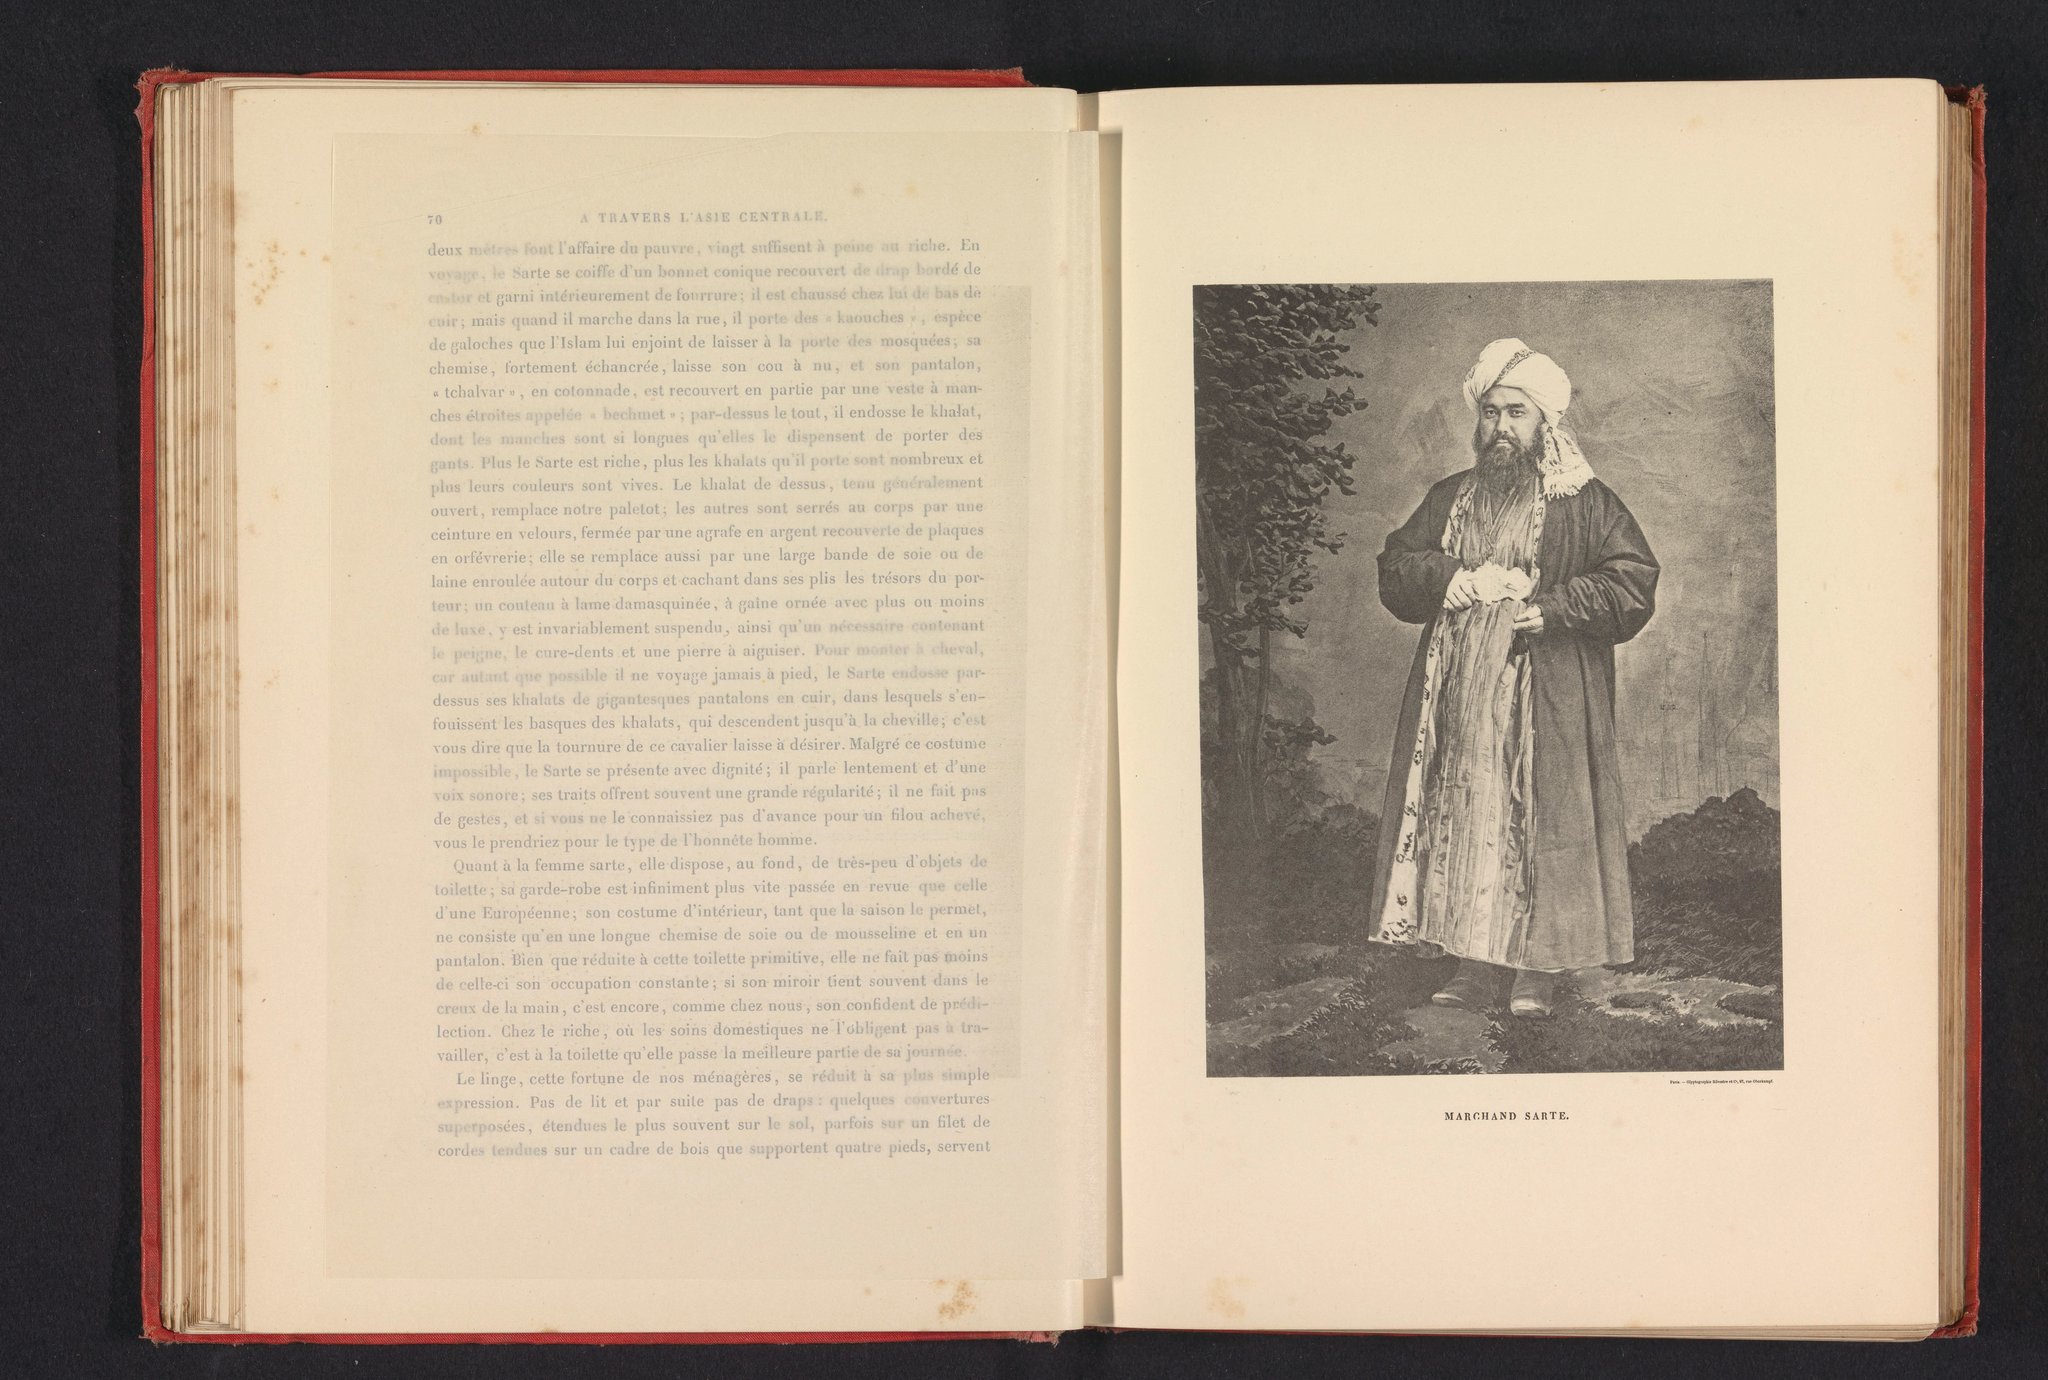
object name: page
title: Portret van een koopman van Sart afkomst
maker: Anonymous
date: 1875-1885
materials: paper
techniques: photograph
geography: central asia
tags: merchant, salesman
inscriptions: name: ‘Silvestre et Cie, 97, rue Oberkampf.’